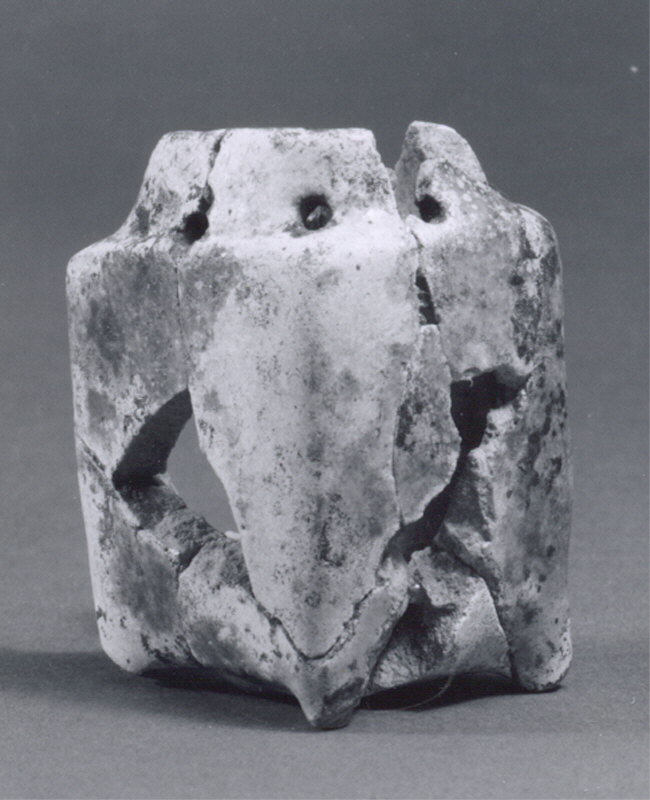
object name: cosmetic container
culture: iranian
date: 900-801 BCE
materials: faience, glaze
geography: iran